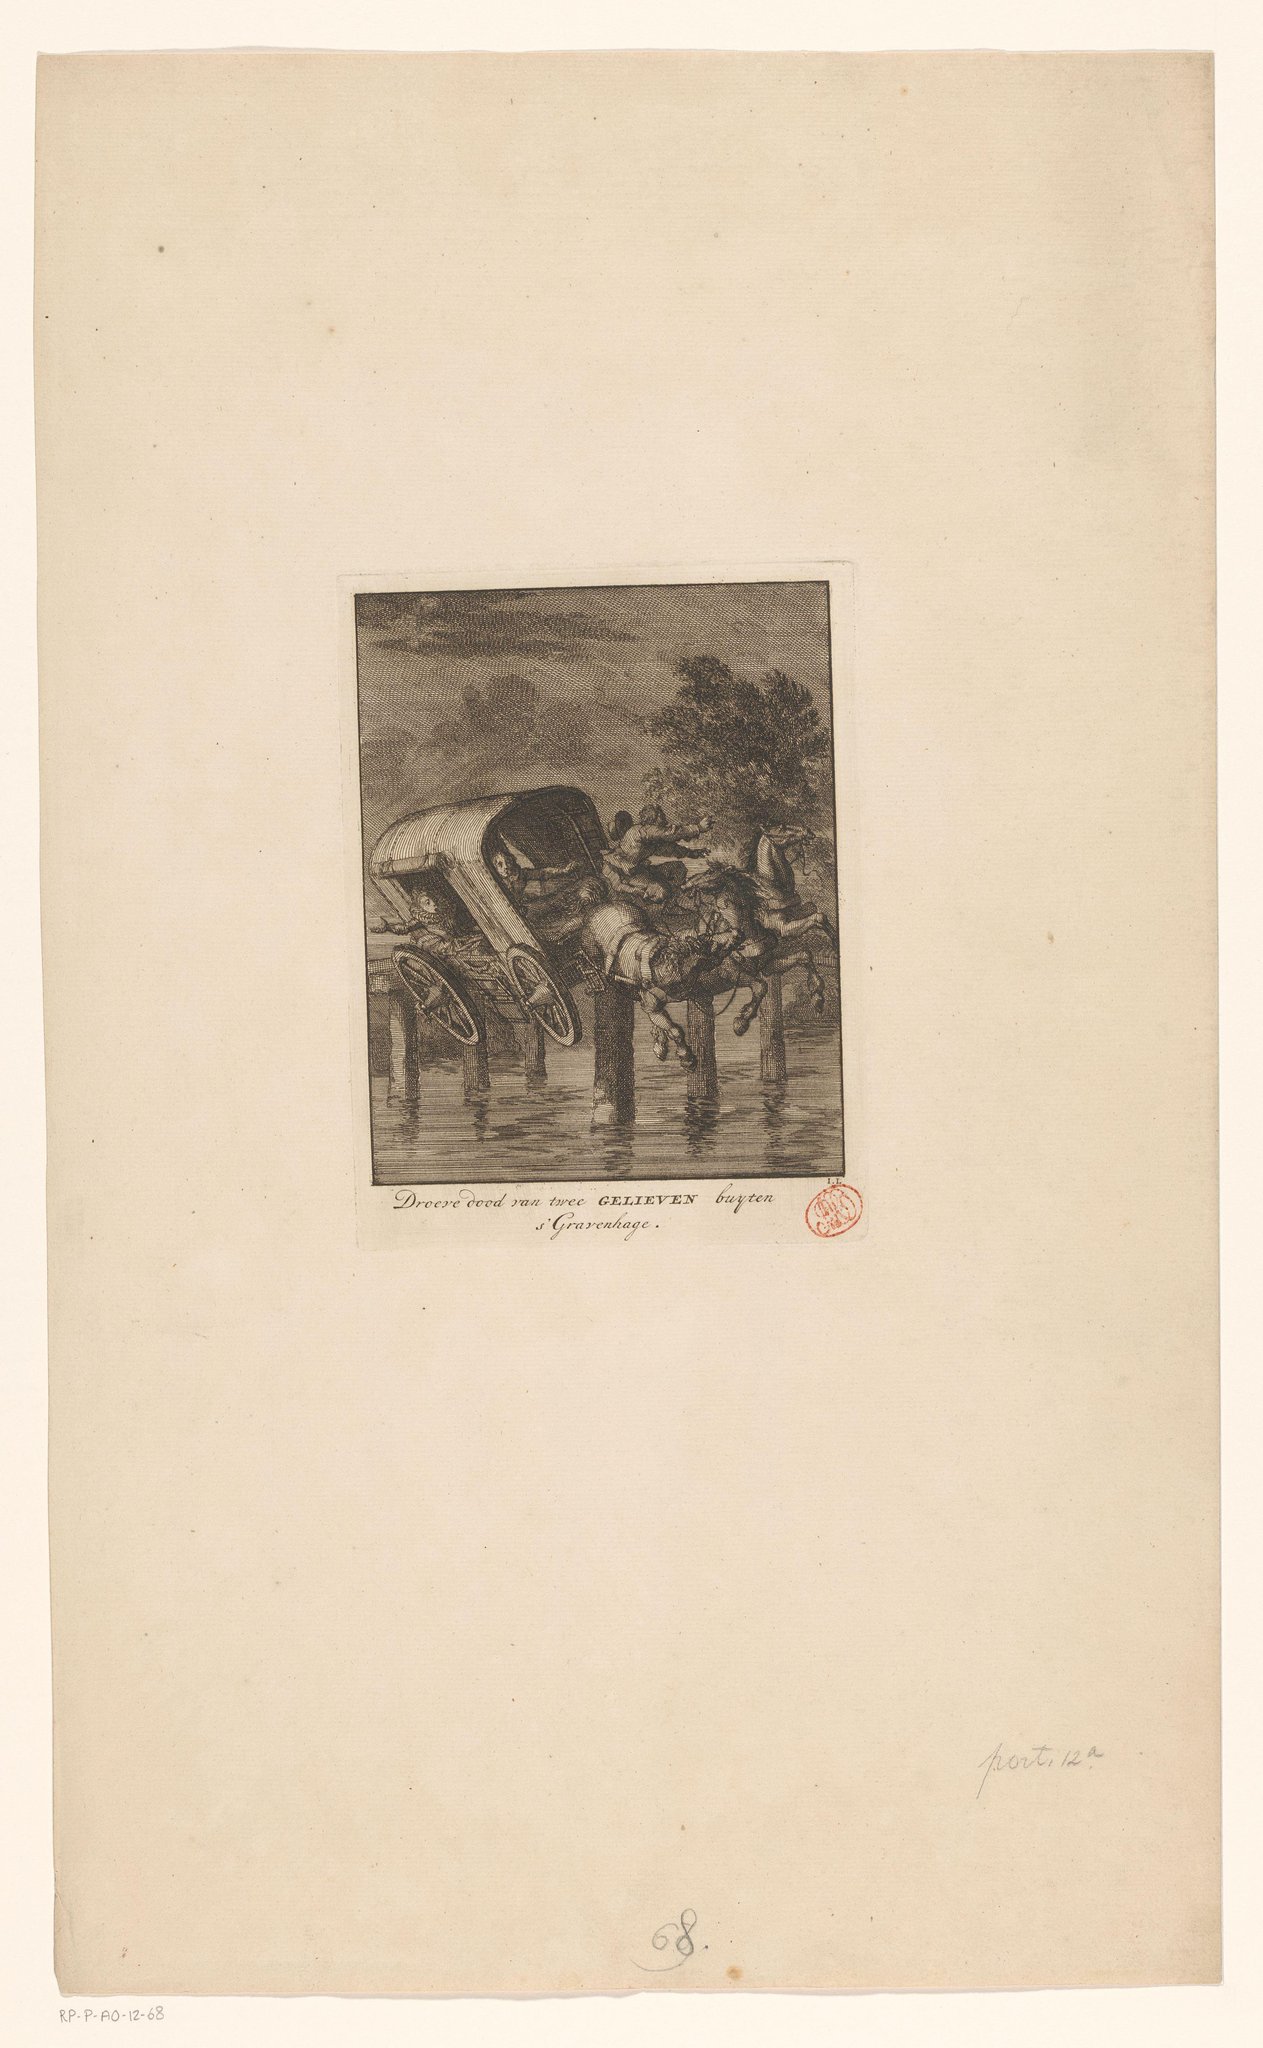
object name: print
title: Droeve dood van twee gelieven buyten s'Gravenhage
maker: jan luyken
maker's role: draughtsman, print maker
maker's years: 1649-1712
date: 1699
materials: paper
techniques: etching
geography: amsterdam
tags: accident with four-wheeled vehicle, drawn by three animals, bridge, the hague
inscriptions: collector's mark: Lugt 195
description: Andere staat van prent ook gebruikt in: Zanten, Laurens van. Treur-tooneel der doorluchtige vrouwen, of op en ondergang der vorstinnen en andere beruchte vrouwelijke personagien (…) met curieuse figuuren, (door J. Luyken gemaakt) verciert. Amsterdam: Jan Claesz ten Hoorn, 1698, afd. 3, p. 139.